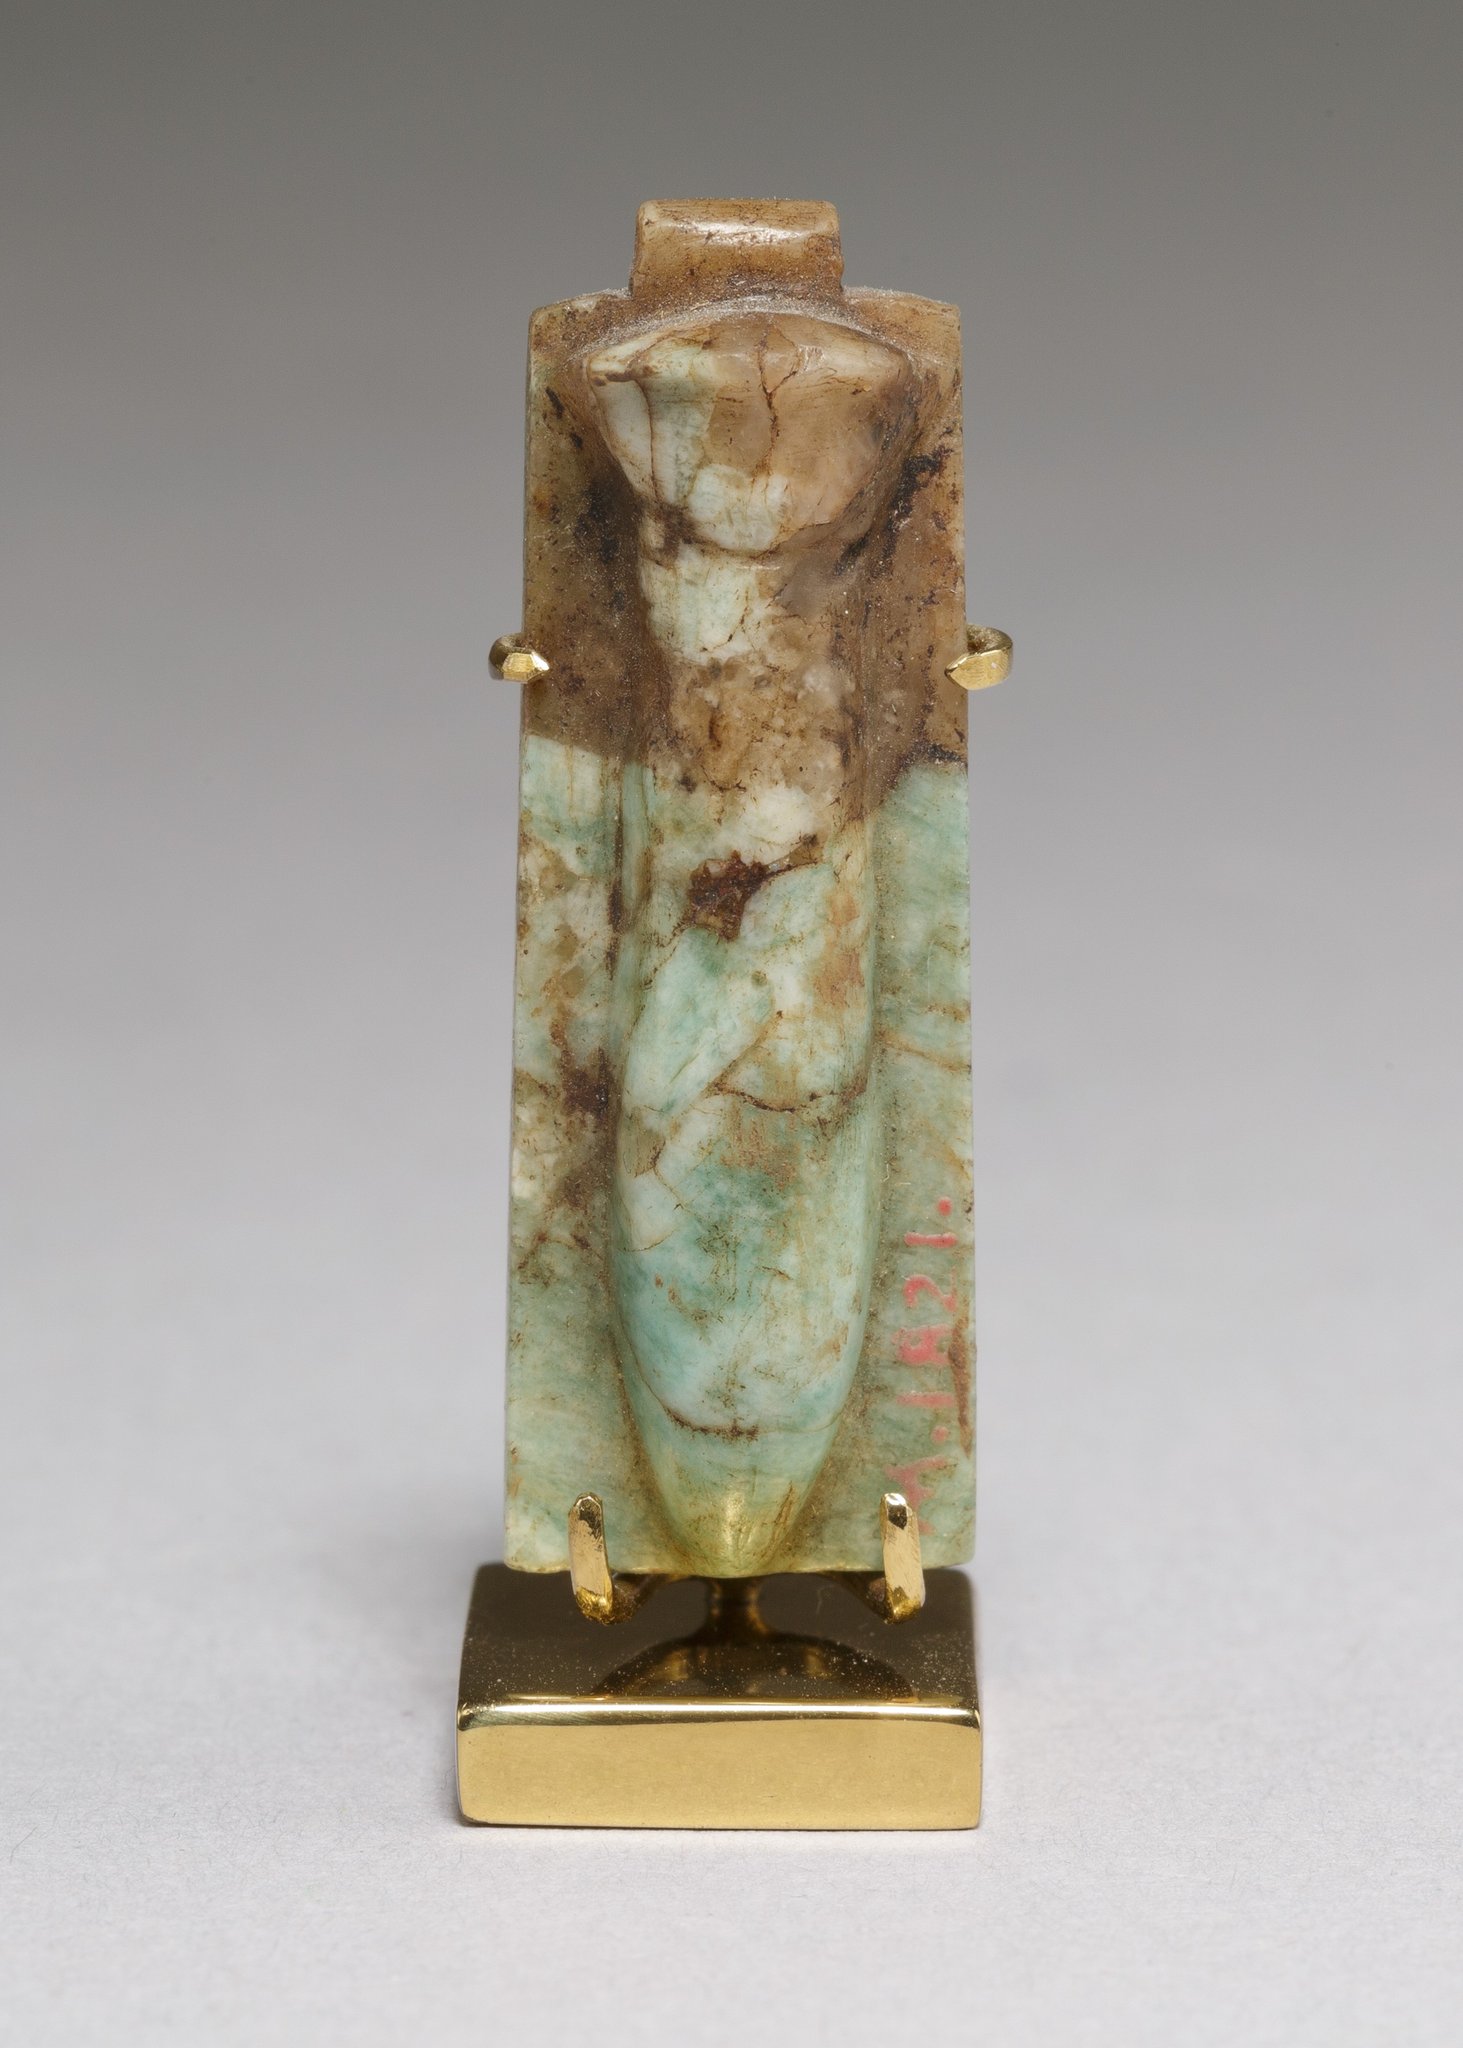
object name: amulet, papyrus column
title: Amulet in the shape of a plaque and with the depiction of a papyrus column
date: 664-630 BCE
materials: stone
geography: egypt